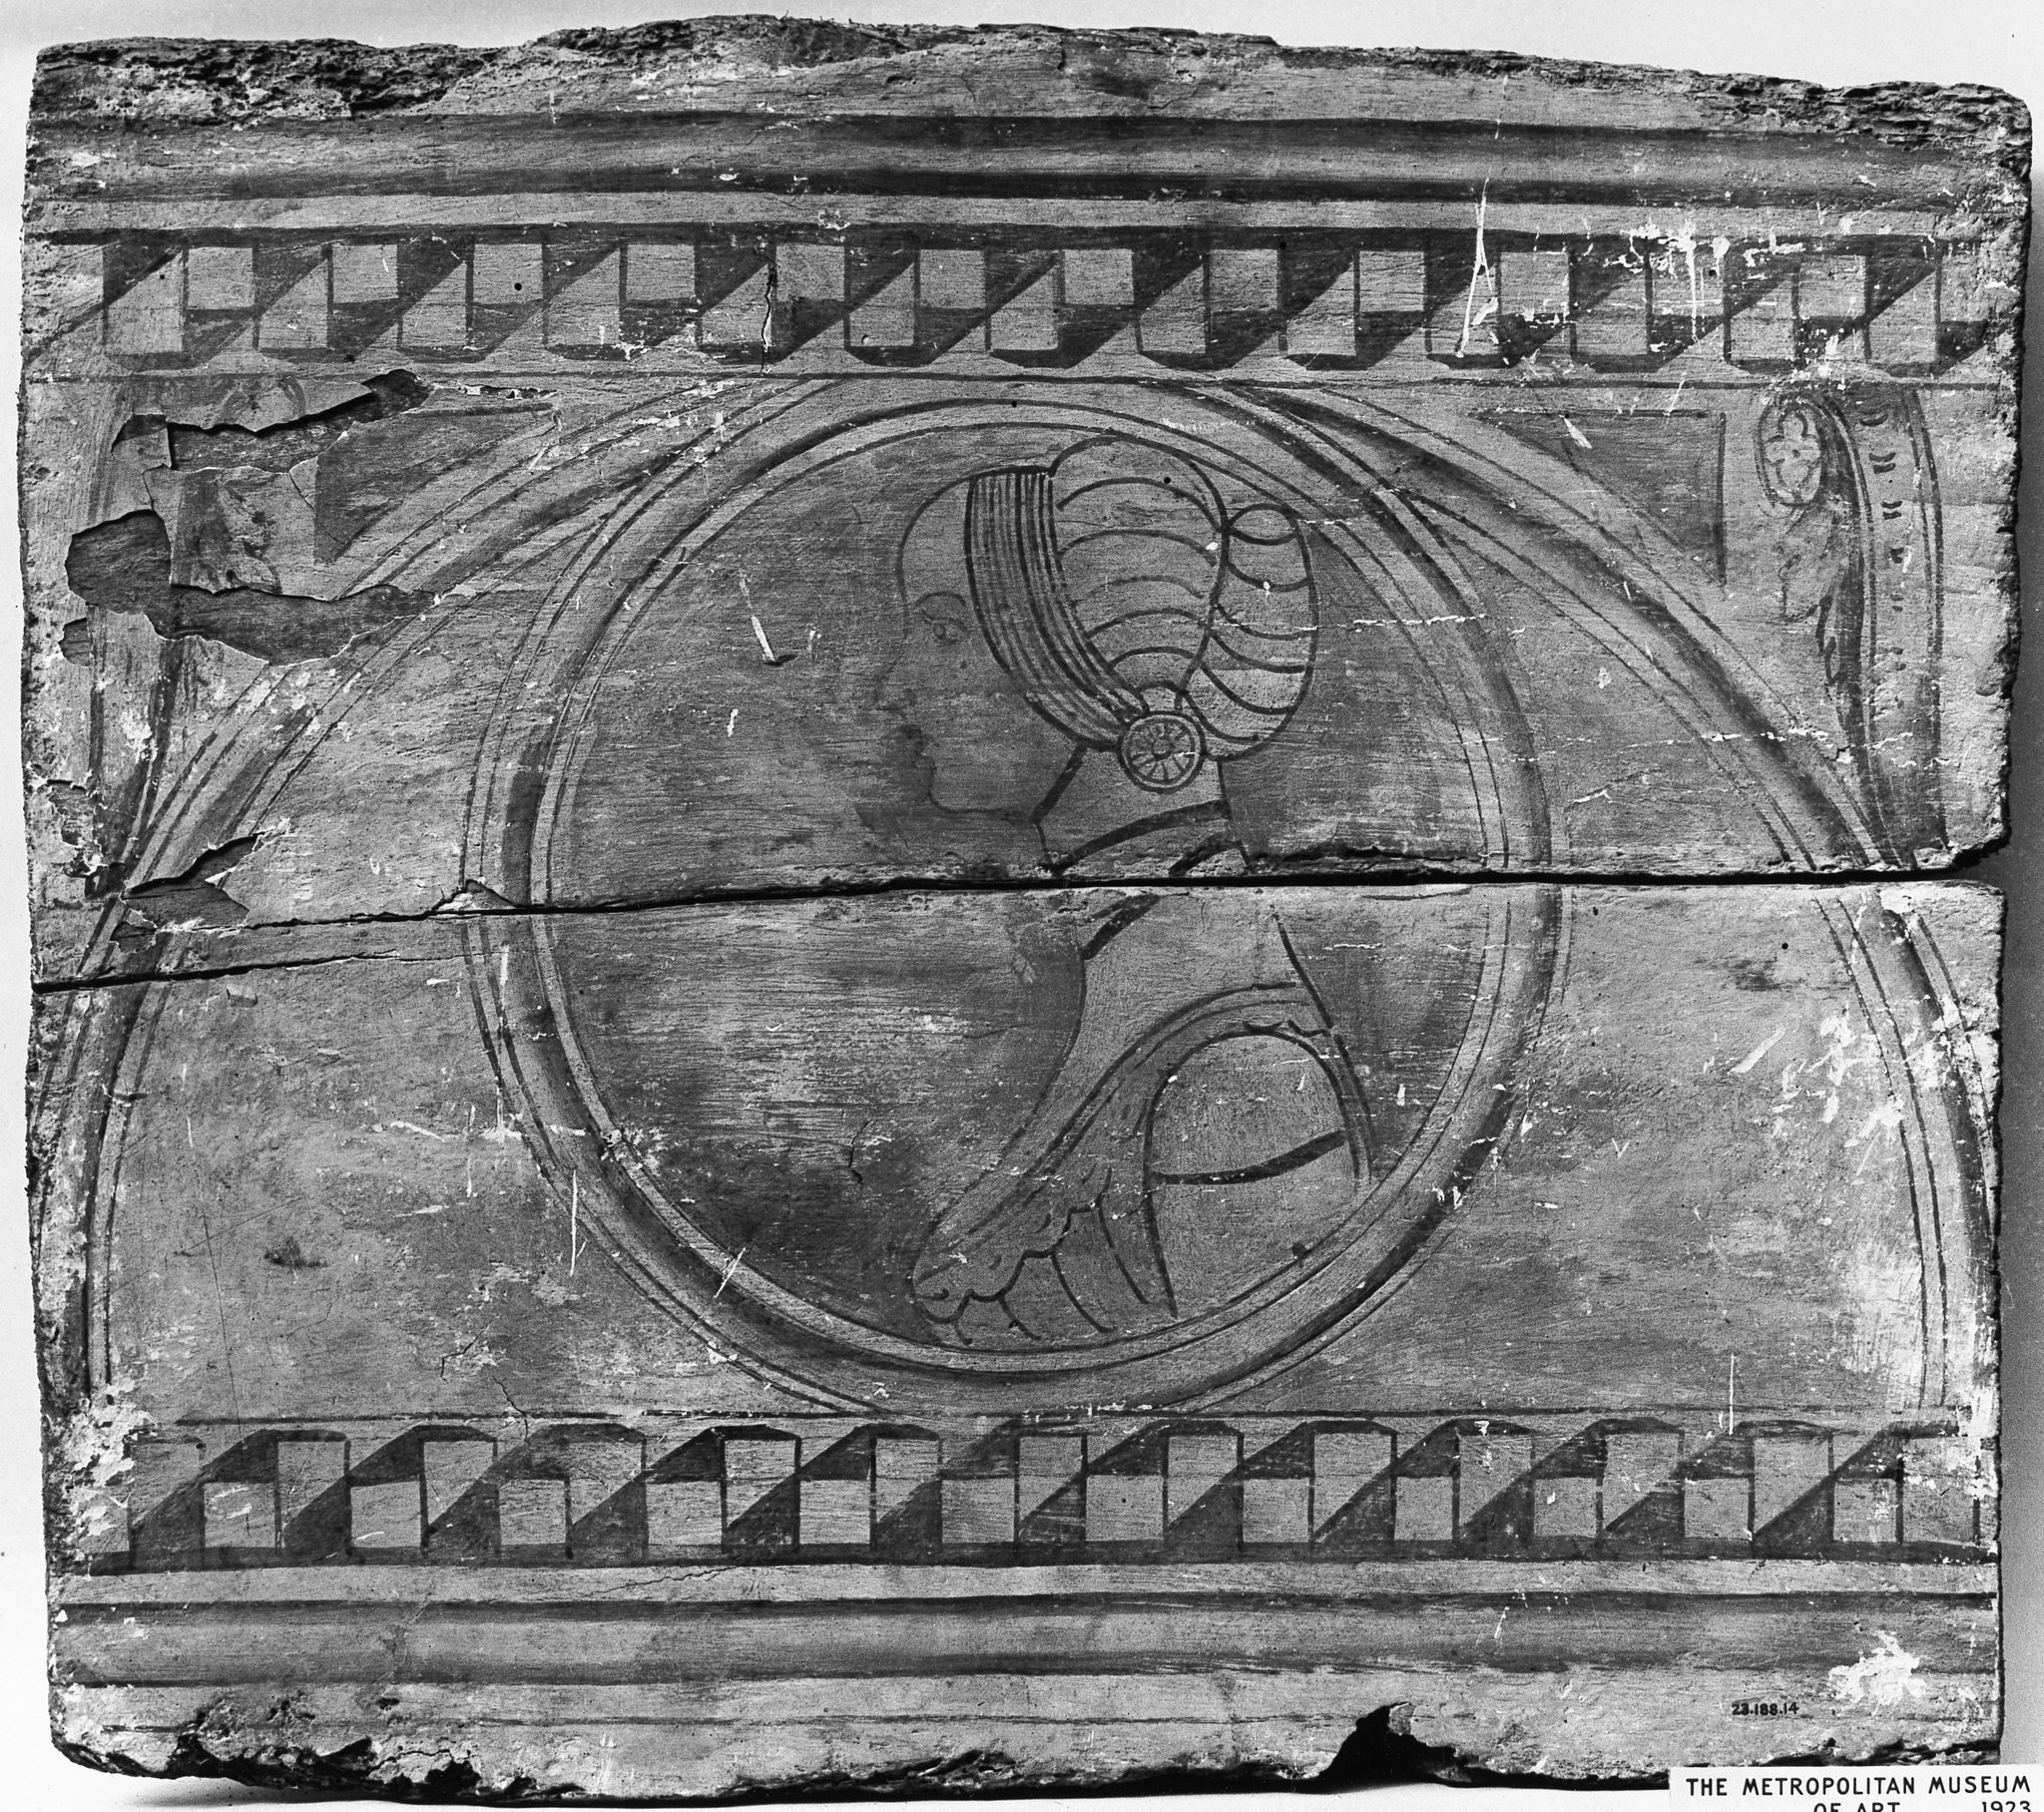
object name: frieze panel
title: Head of a woman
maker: north italian painter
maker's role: artist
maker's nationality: italian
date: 1467-1500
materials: paint, wood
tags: profiles,women